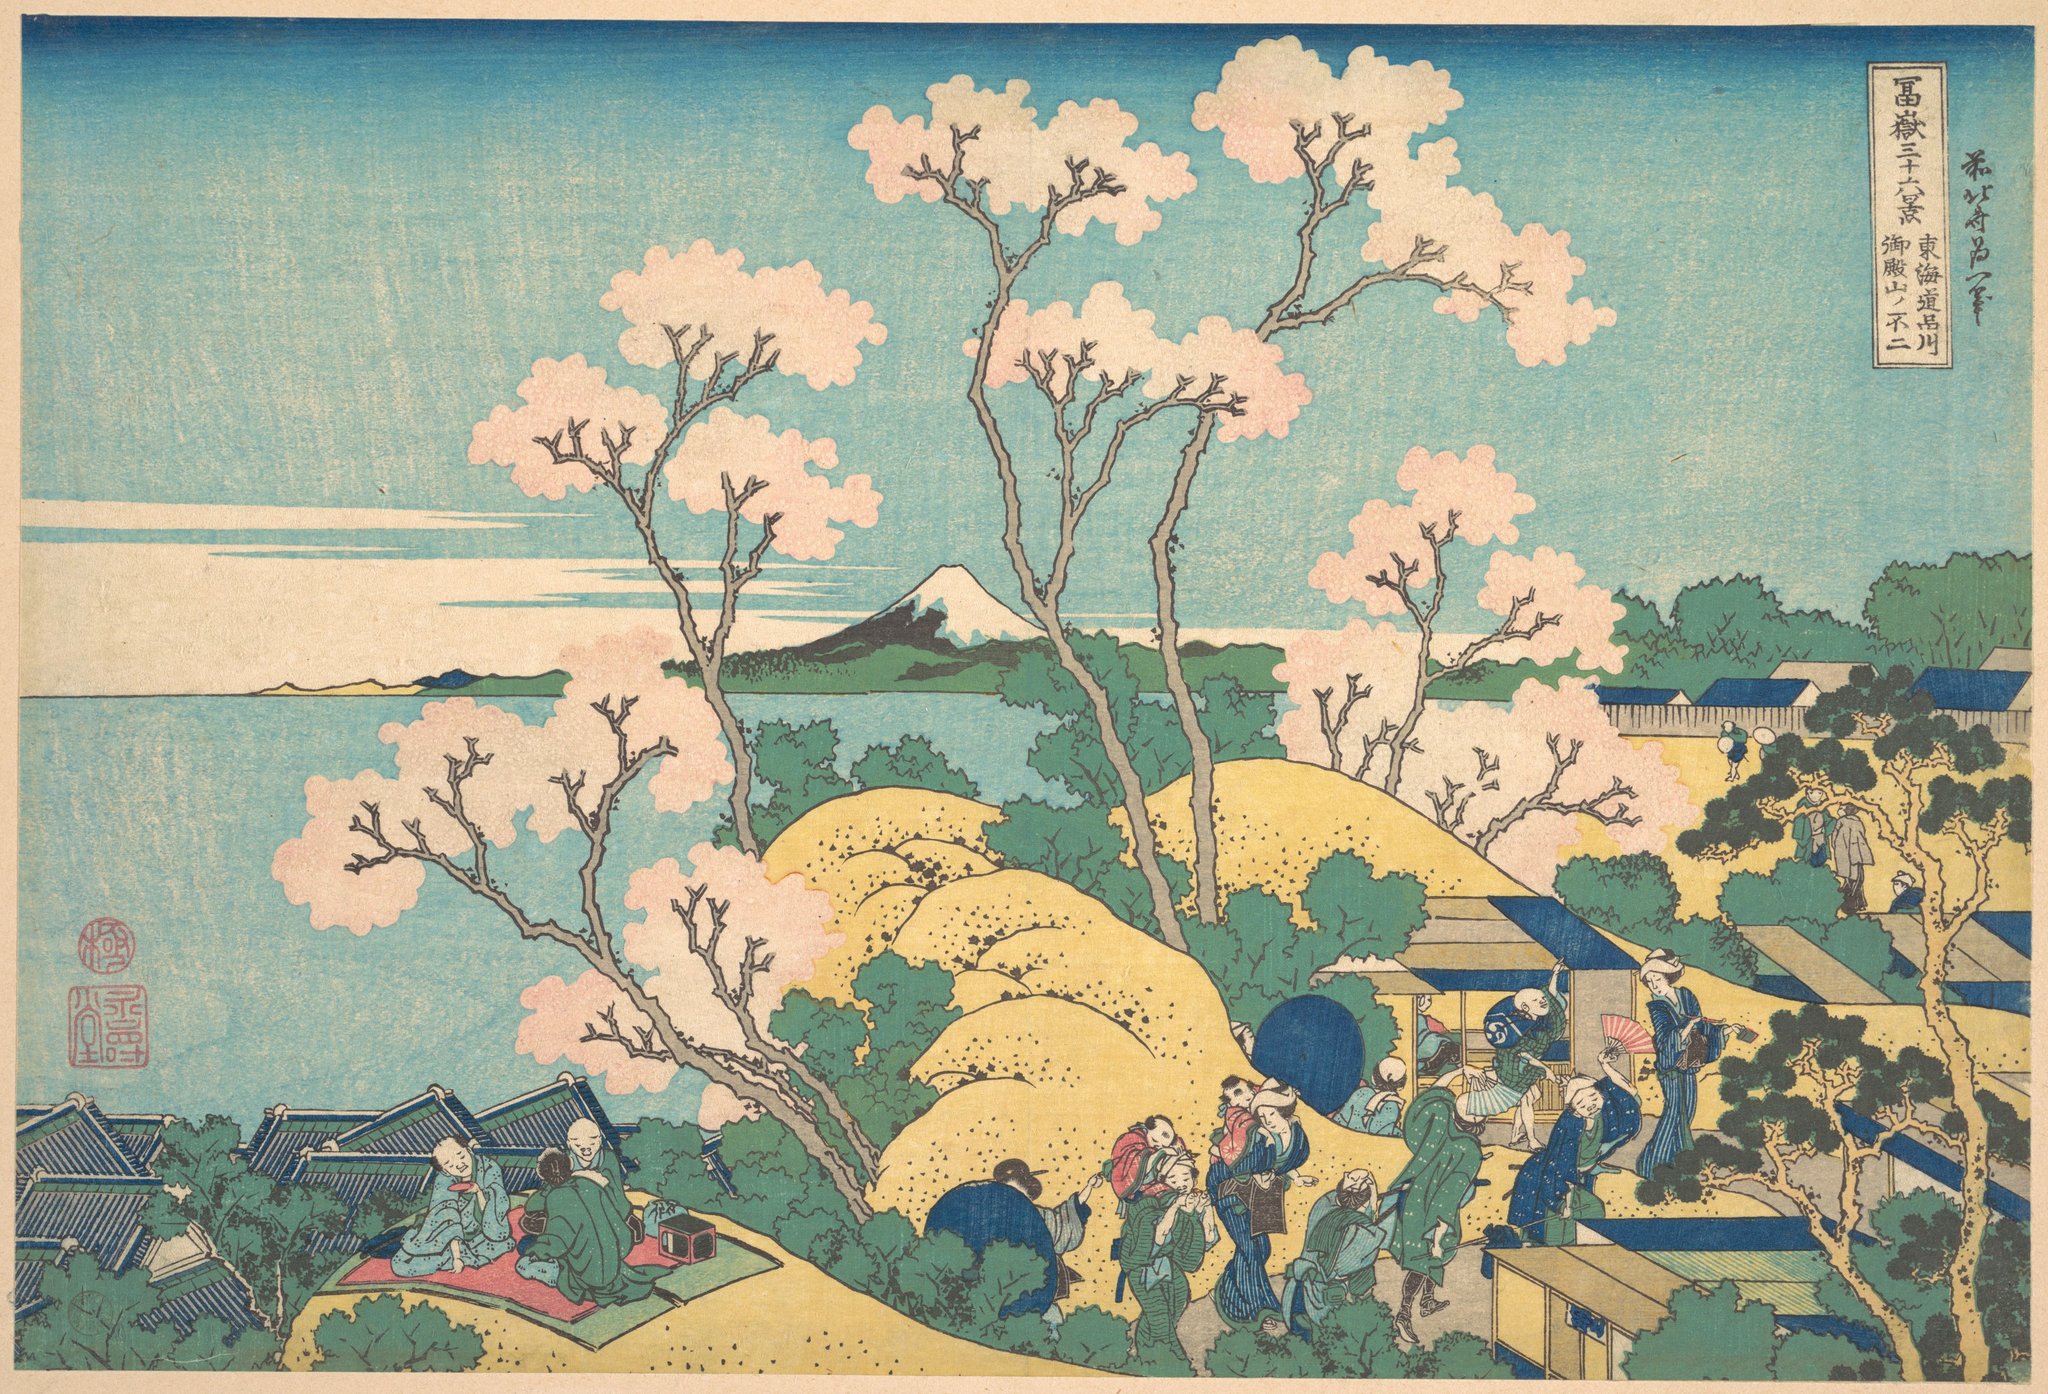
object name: woodblock print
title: Fuji from Gotenyama on the Tōkaidō at Shinagawa (Tōkaidō Shinagawa Gotenyama no Fuji), from the series Thirty-six Views of Mount Fuji (Fugaku sanjūrokkei)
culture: japanese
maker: katsushika hokusai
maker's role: artist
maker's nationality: japanese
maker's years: 1760-1849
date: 1830-1832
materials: ink, paper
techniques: woodblock print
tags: houses,men,women,mountains,trees